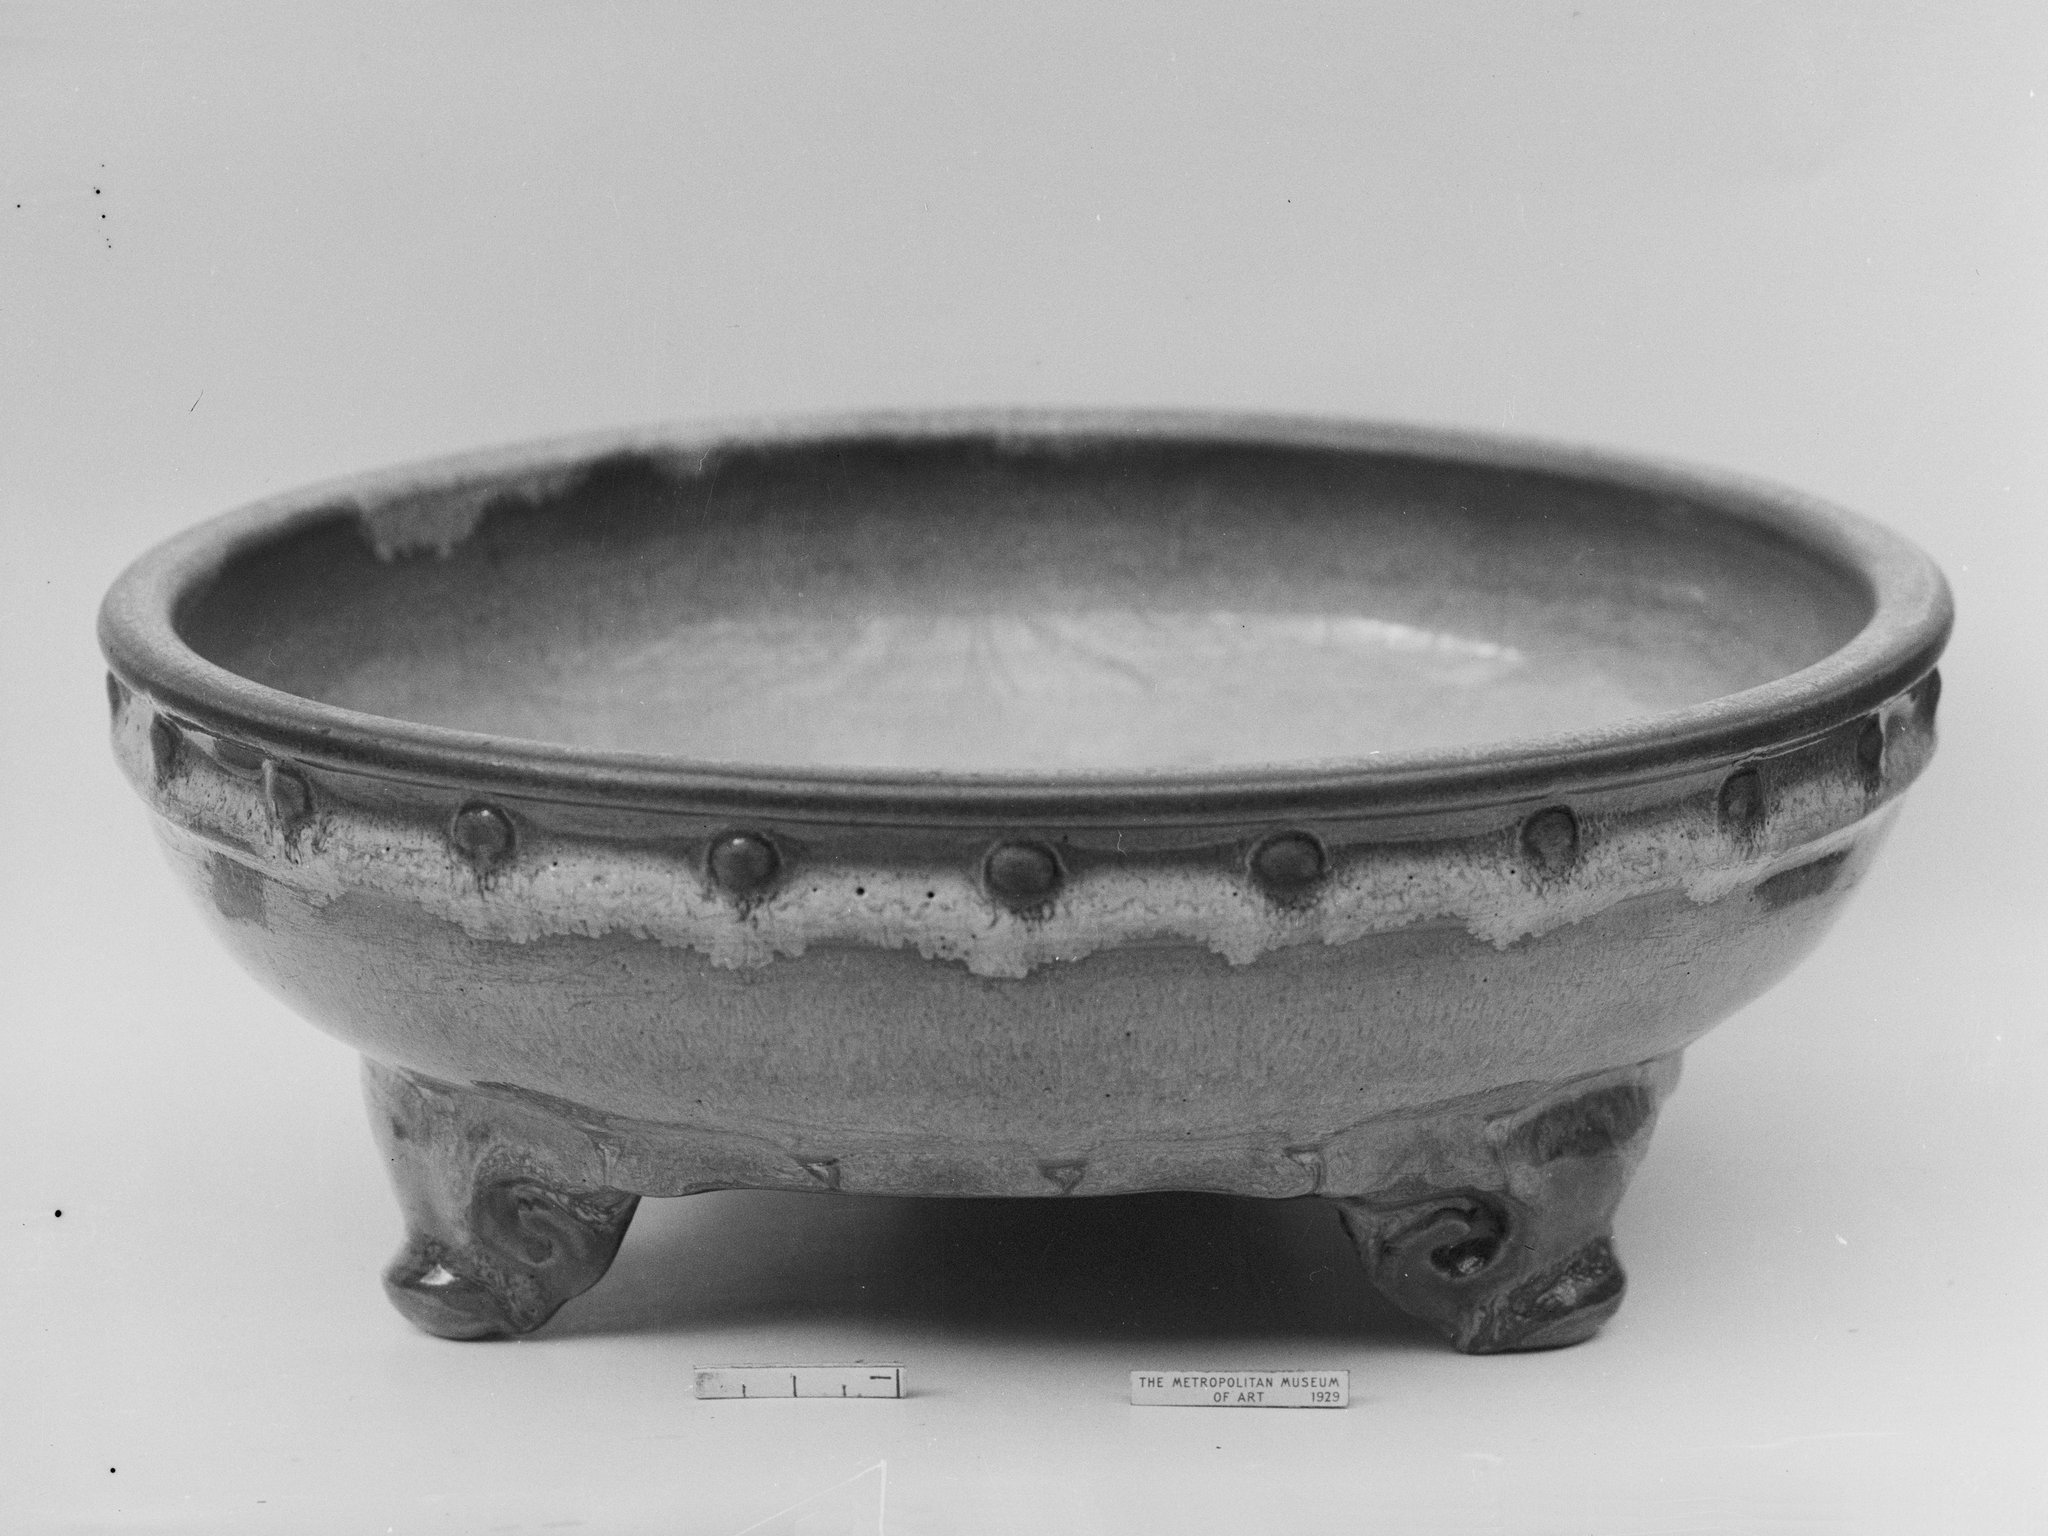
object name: bowl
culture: chinese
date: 960-1279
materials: pottery